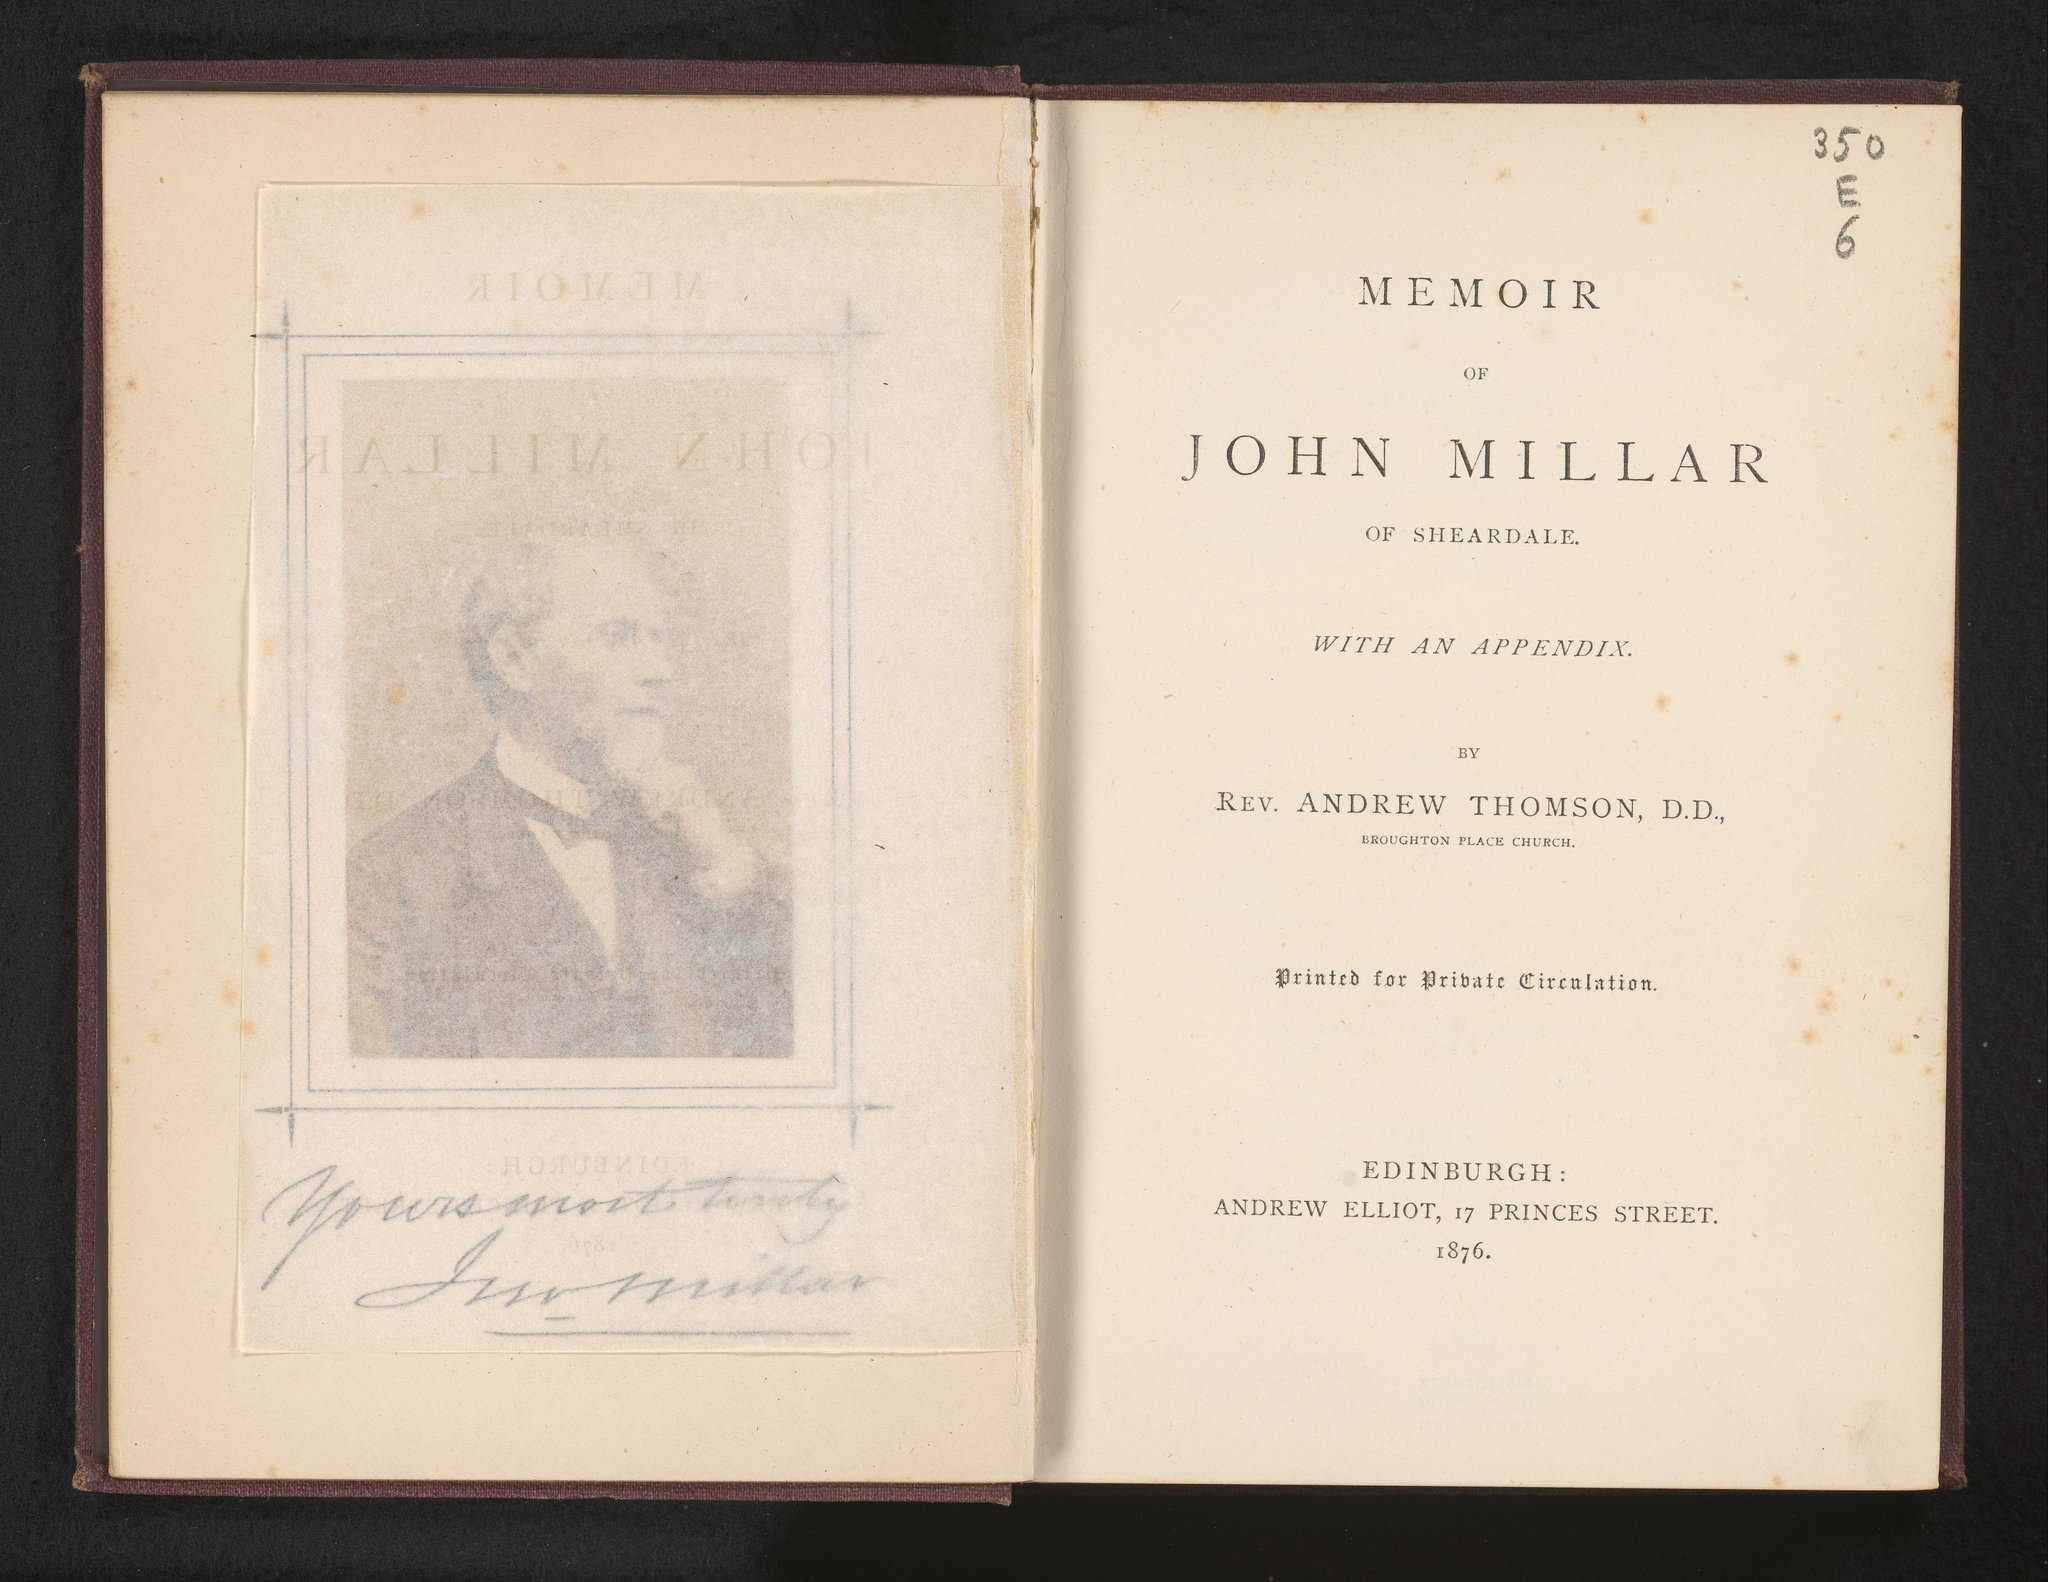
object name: book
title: Memoir of John Millar of Sheardale, with an appendix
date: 1876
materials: cardboard, paper, linen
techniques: albumen print, letterpress printing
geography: edinburgh